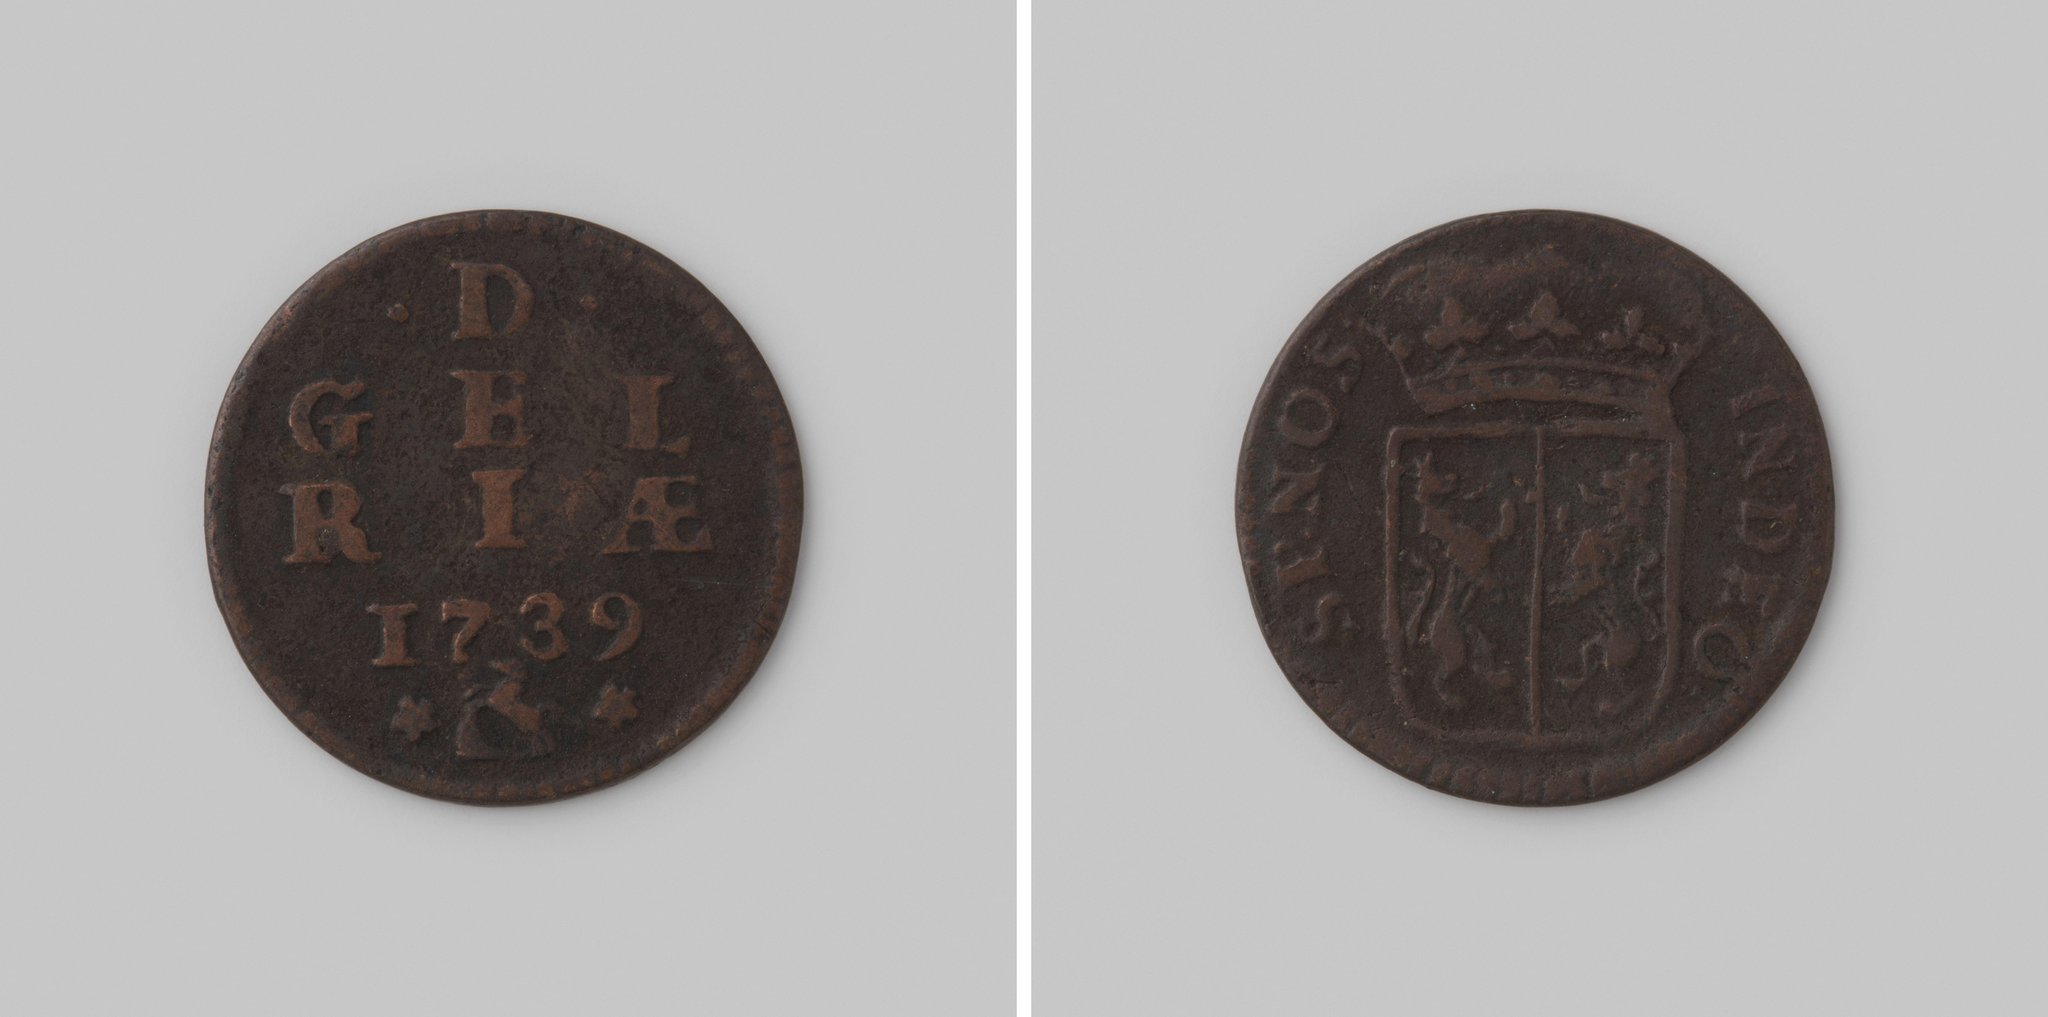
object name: coin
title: Gelderland, duit, 1739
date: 1739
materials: copper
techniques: striking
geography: harderwijk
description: Koperen munt. Voorzijde: in drie regels D/GEL/RIAE, daaronder jaartal en muntmeesterteken. Keerzijde: gekroond Gelders wapenschild.